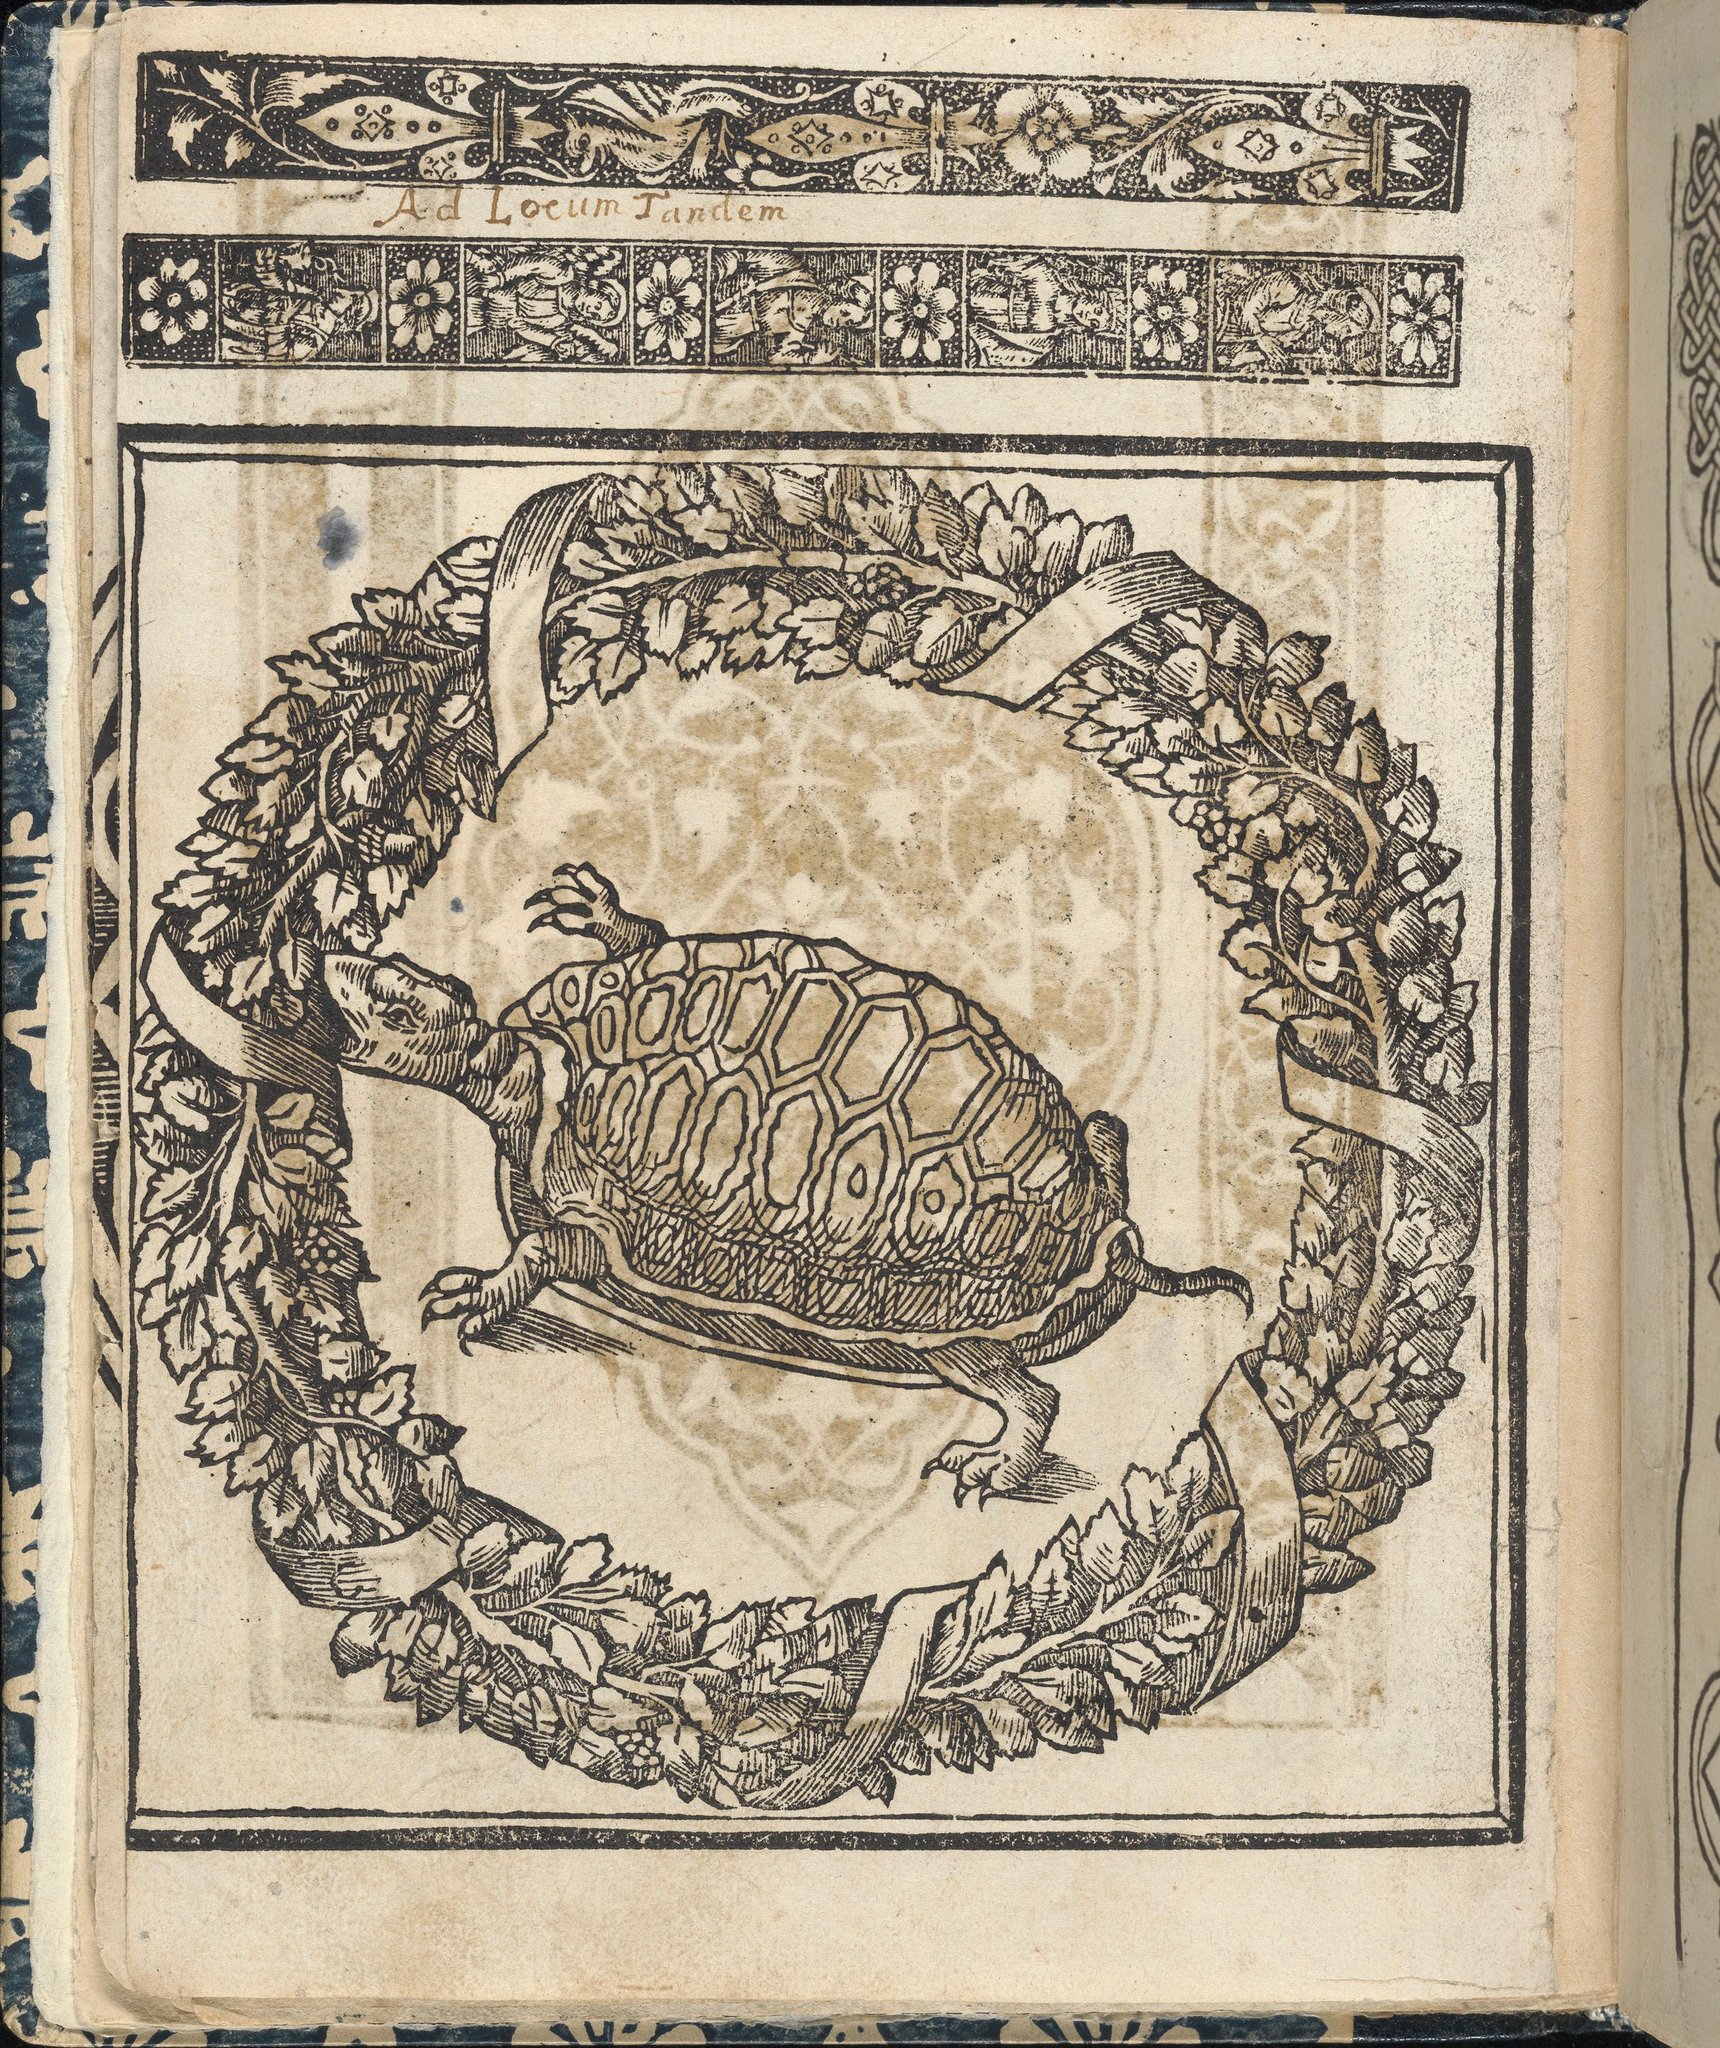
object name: book print ornament architecture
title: Essempio di recammi, page 23 (verso)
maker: giovanni antonio tagliente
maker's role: author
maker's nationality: italian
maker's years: 1465-1528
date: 1530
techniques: woodcut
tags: garlands,turtles,flowers,wreaths